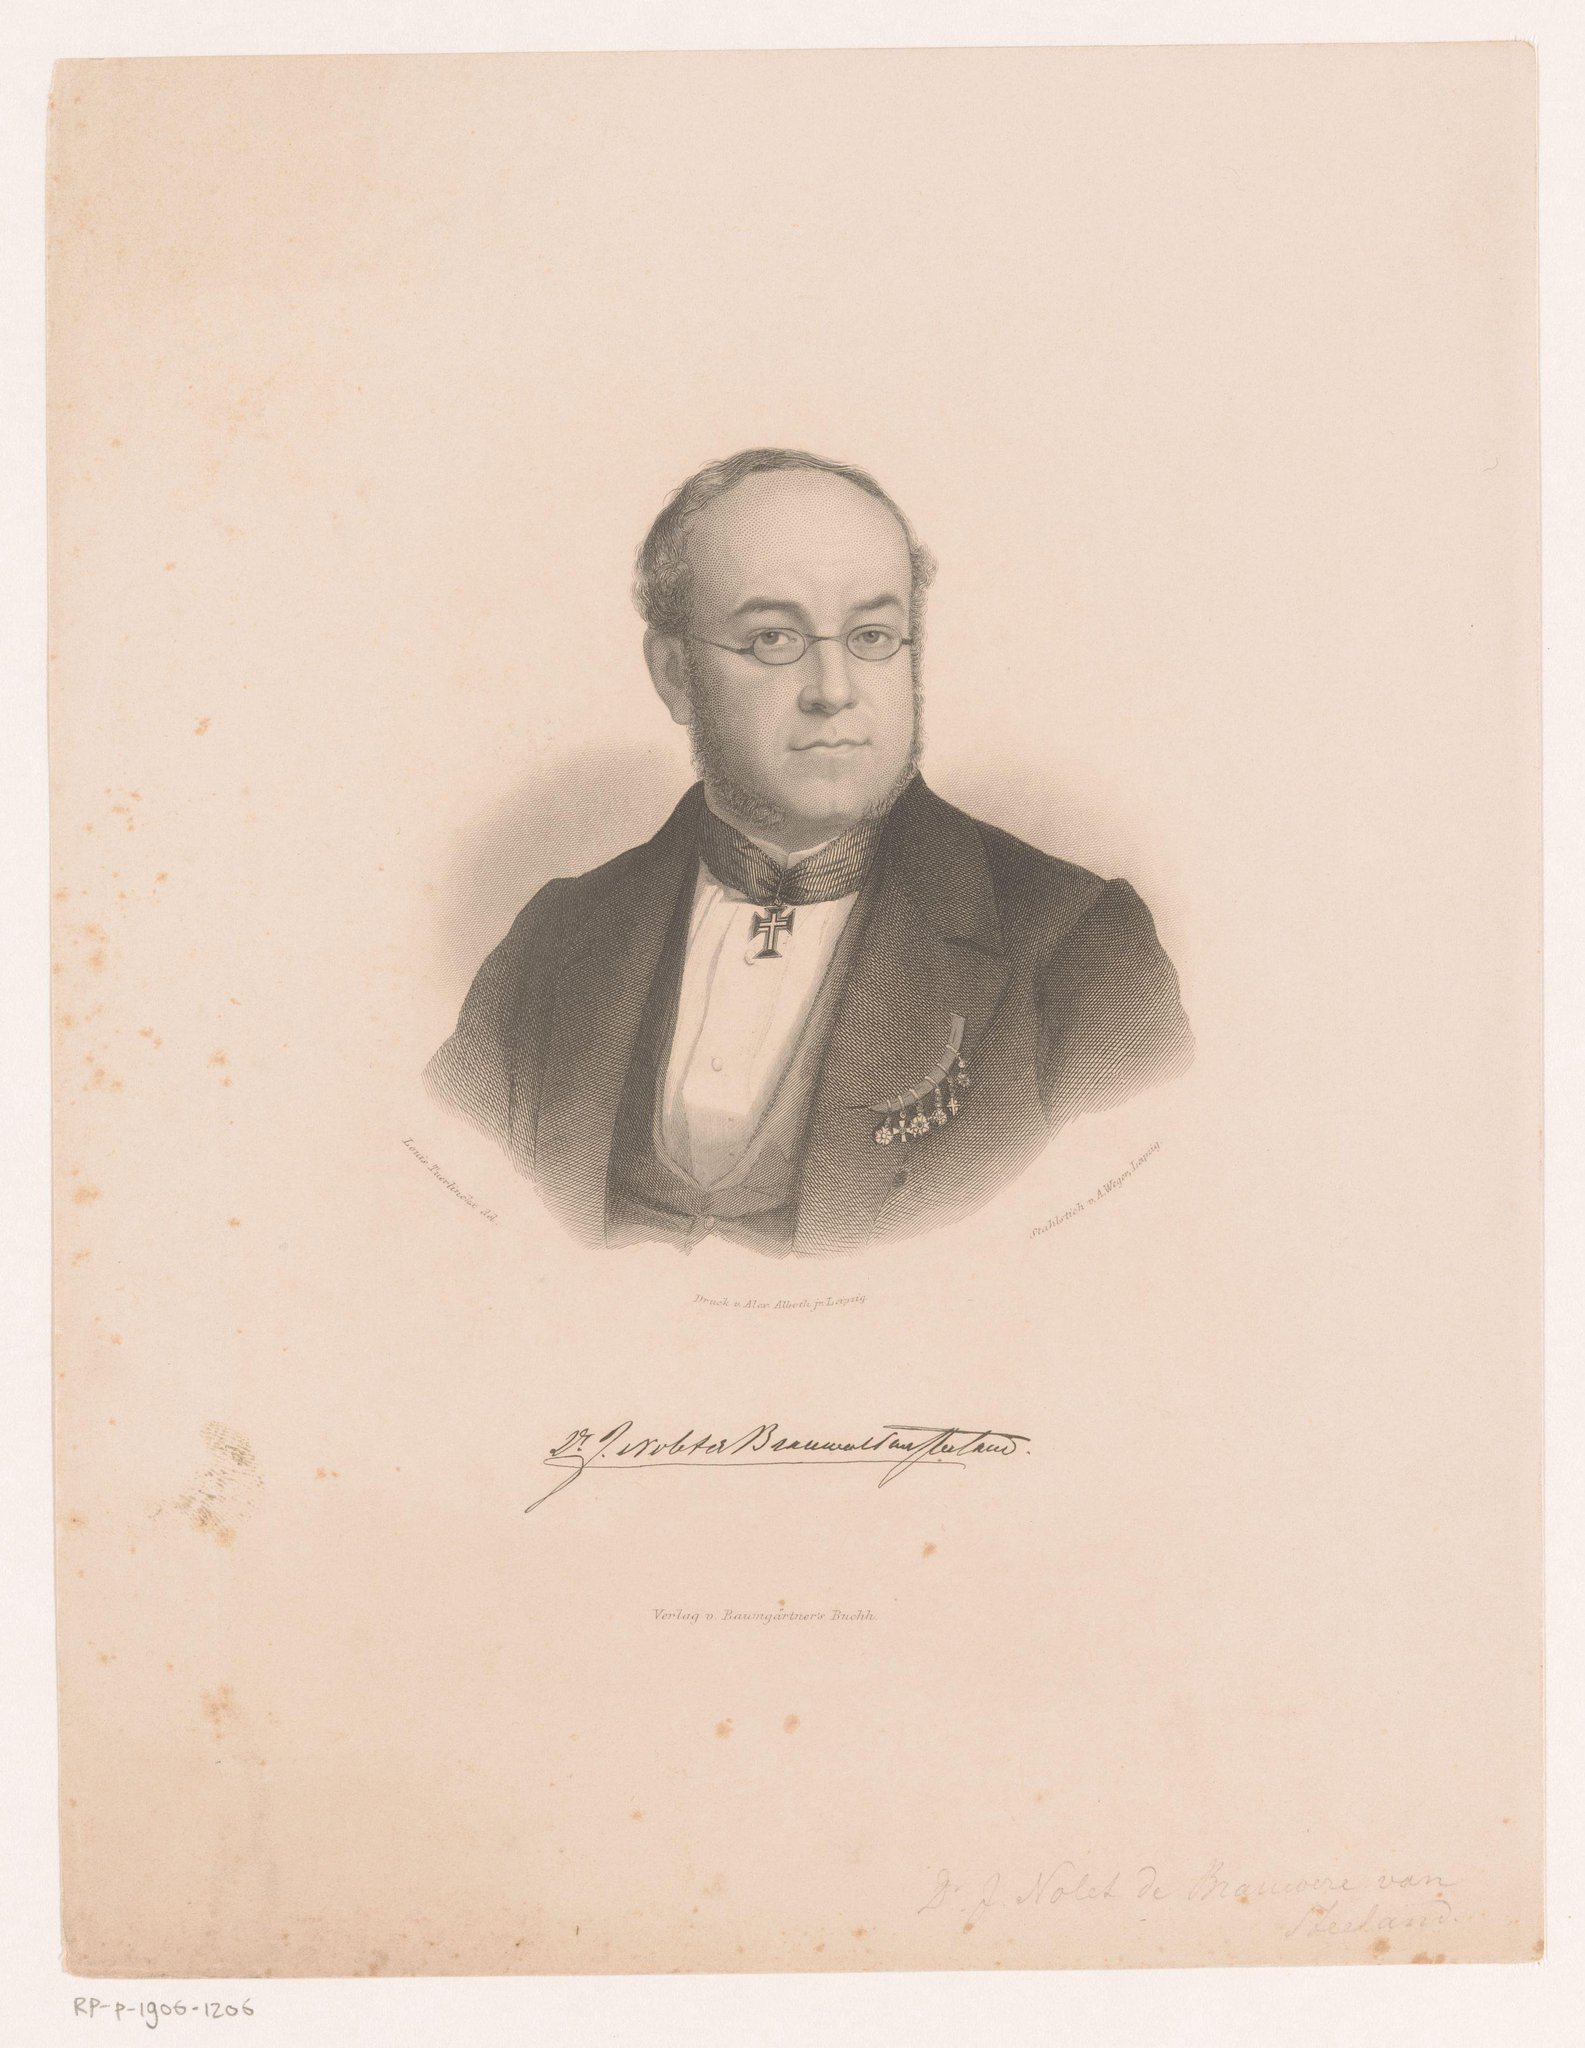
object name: print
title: Portret van Jan Nolet de Brauwere van Steeland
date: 1849-1892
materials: paper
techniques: engraving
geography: leipzig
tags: rotterdam, historical persons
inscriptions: collector's mark: Lugt 2228